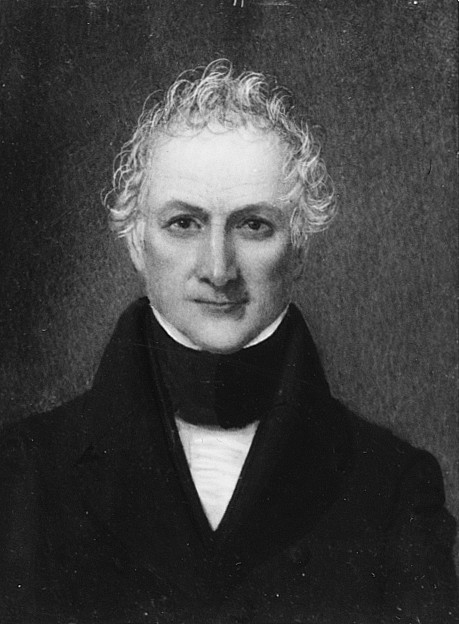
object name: painting, miniature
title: Warren Rogers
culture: american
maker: theodore lund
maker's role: artist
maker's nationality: american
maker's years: 1810-1895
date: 1839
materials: ivory, watercolor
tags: men,portraits